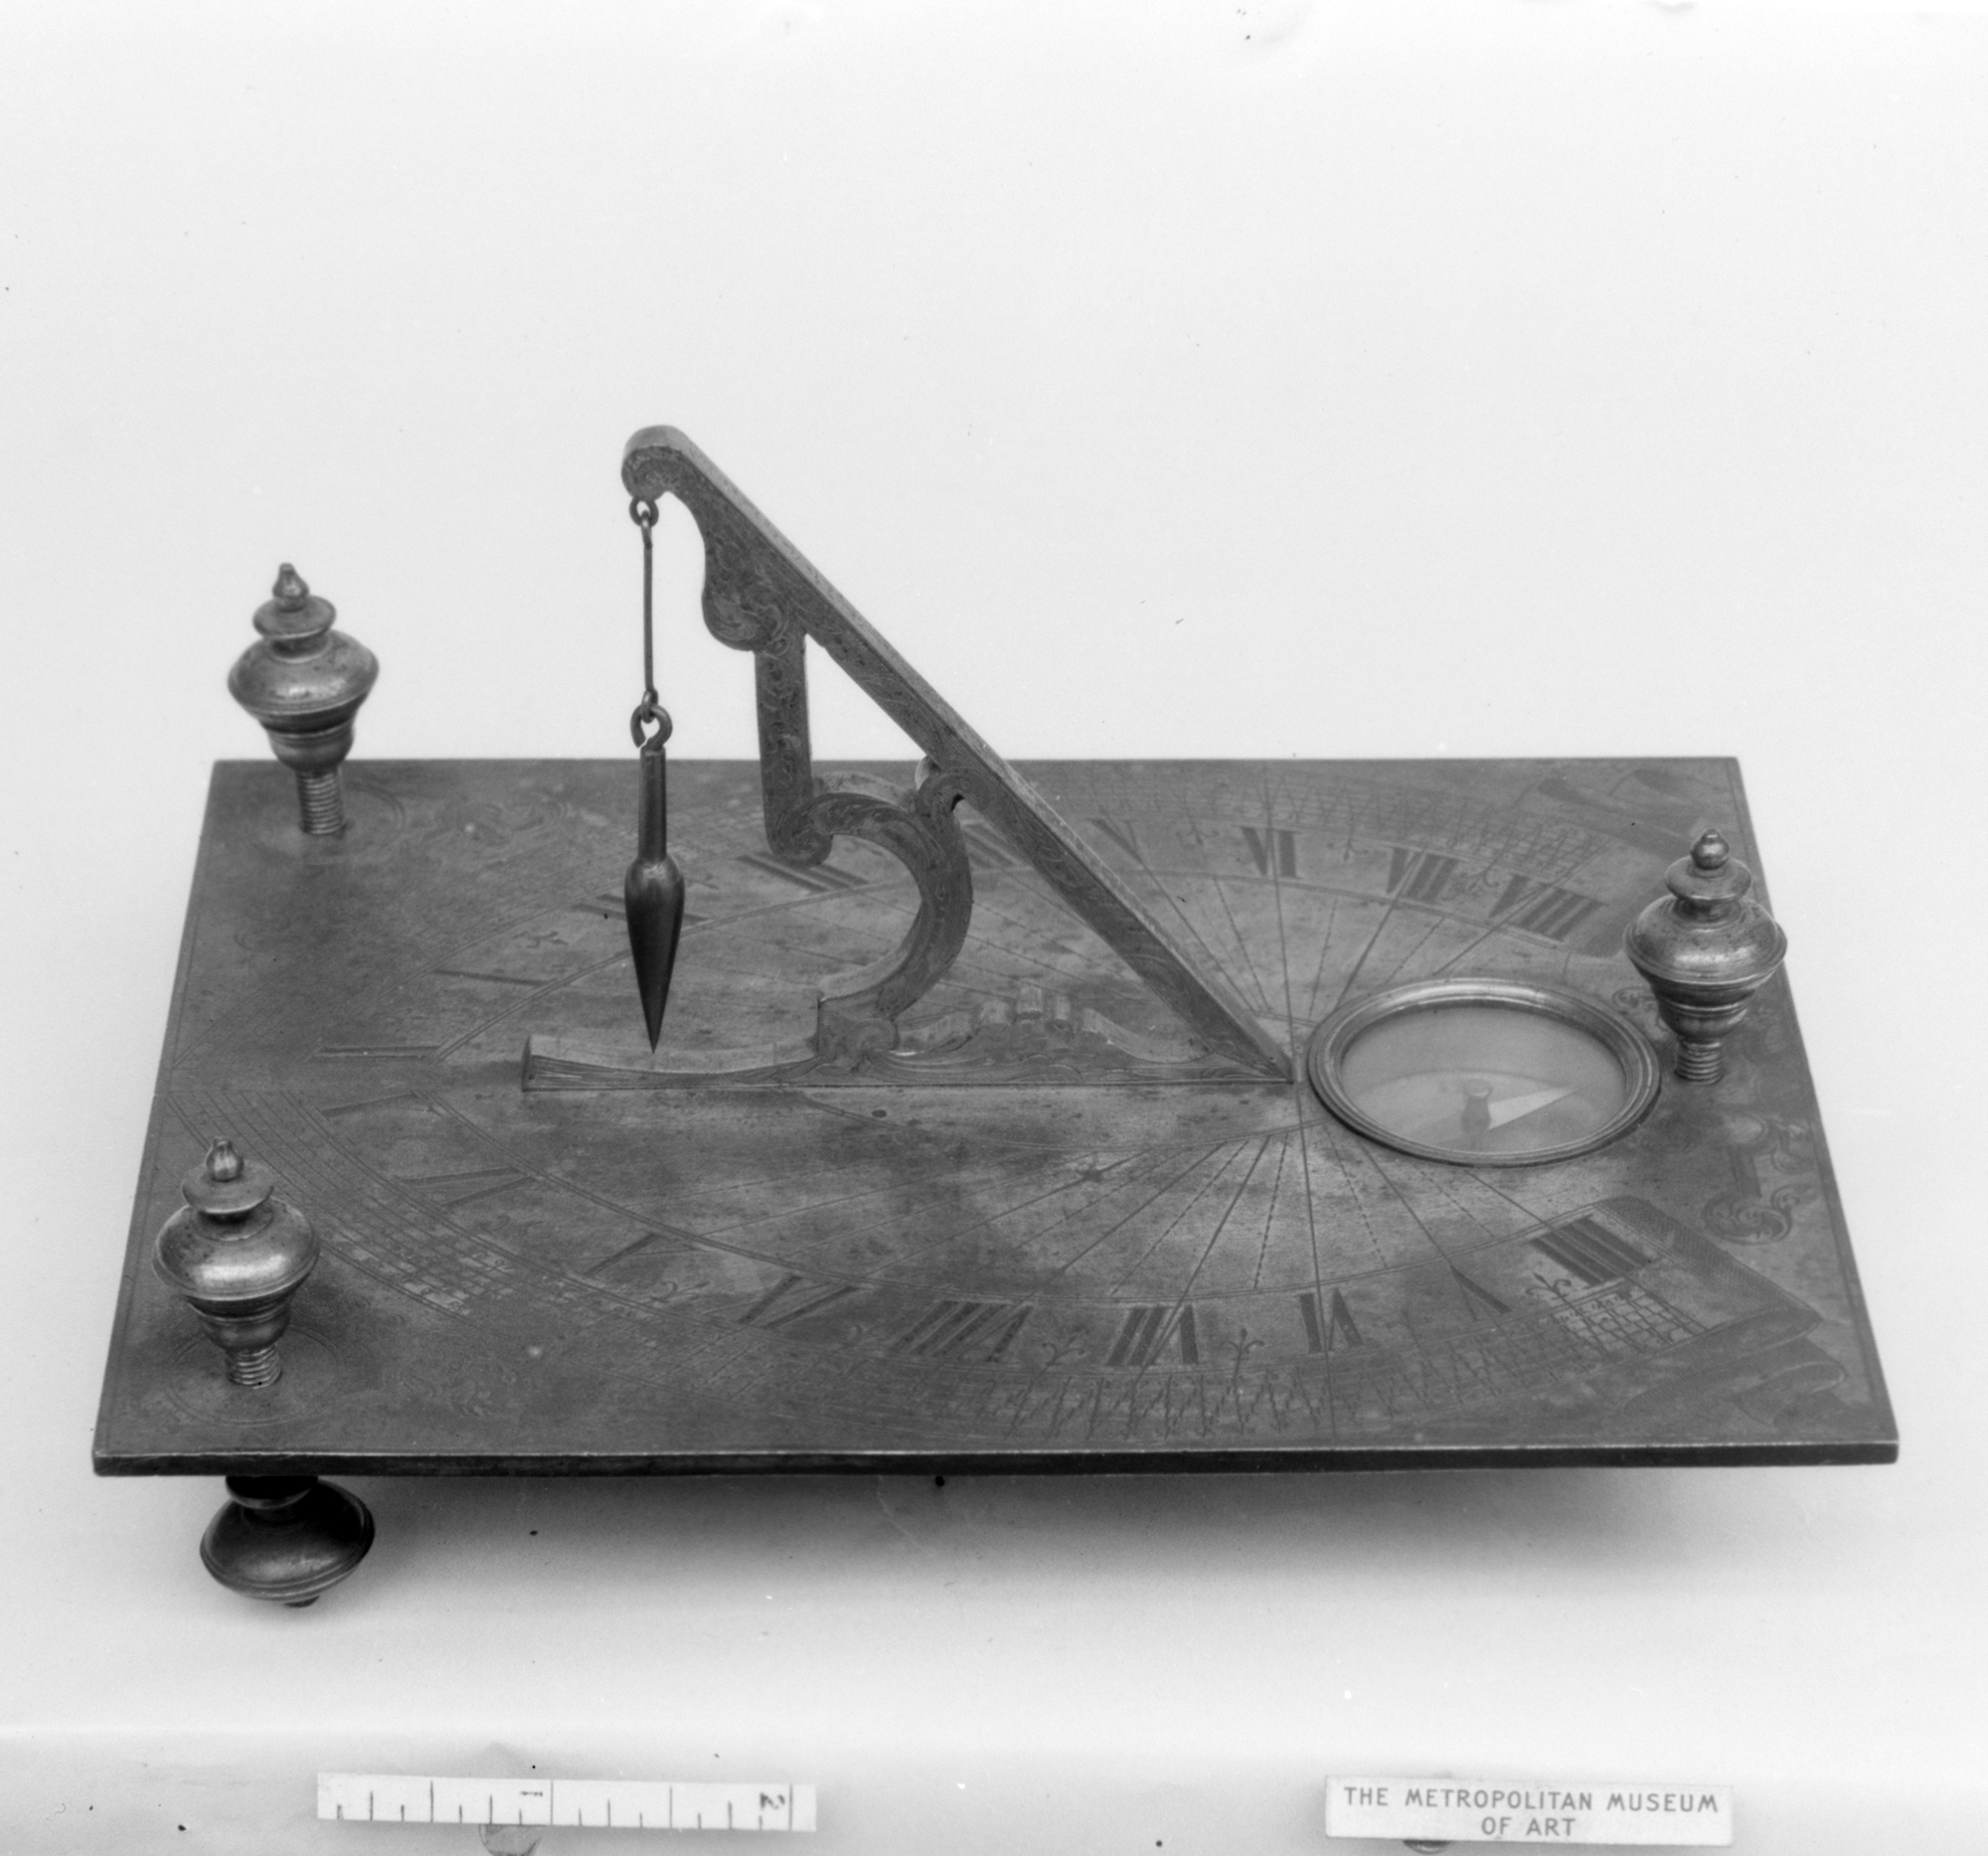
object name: portable compass dial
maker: johann klocksperger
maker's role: maker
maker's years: 1650-1750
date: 1667-1733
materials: brass, silver